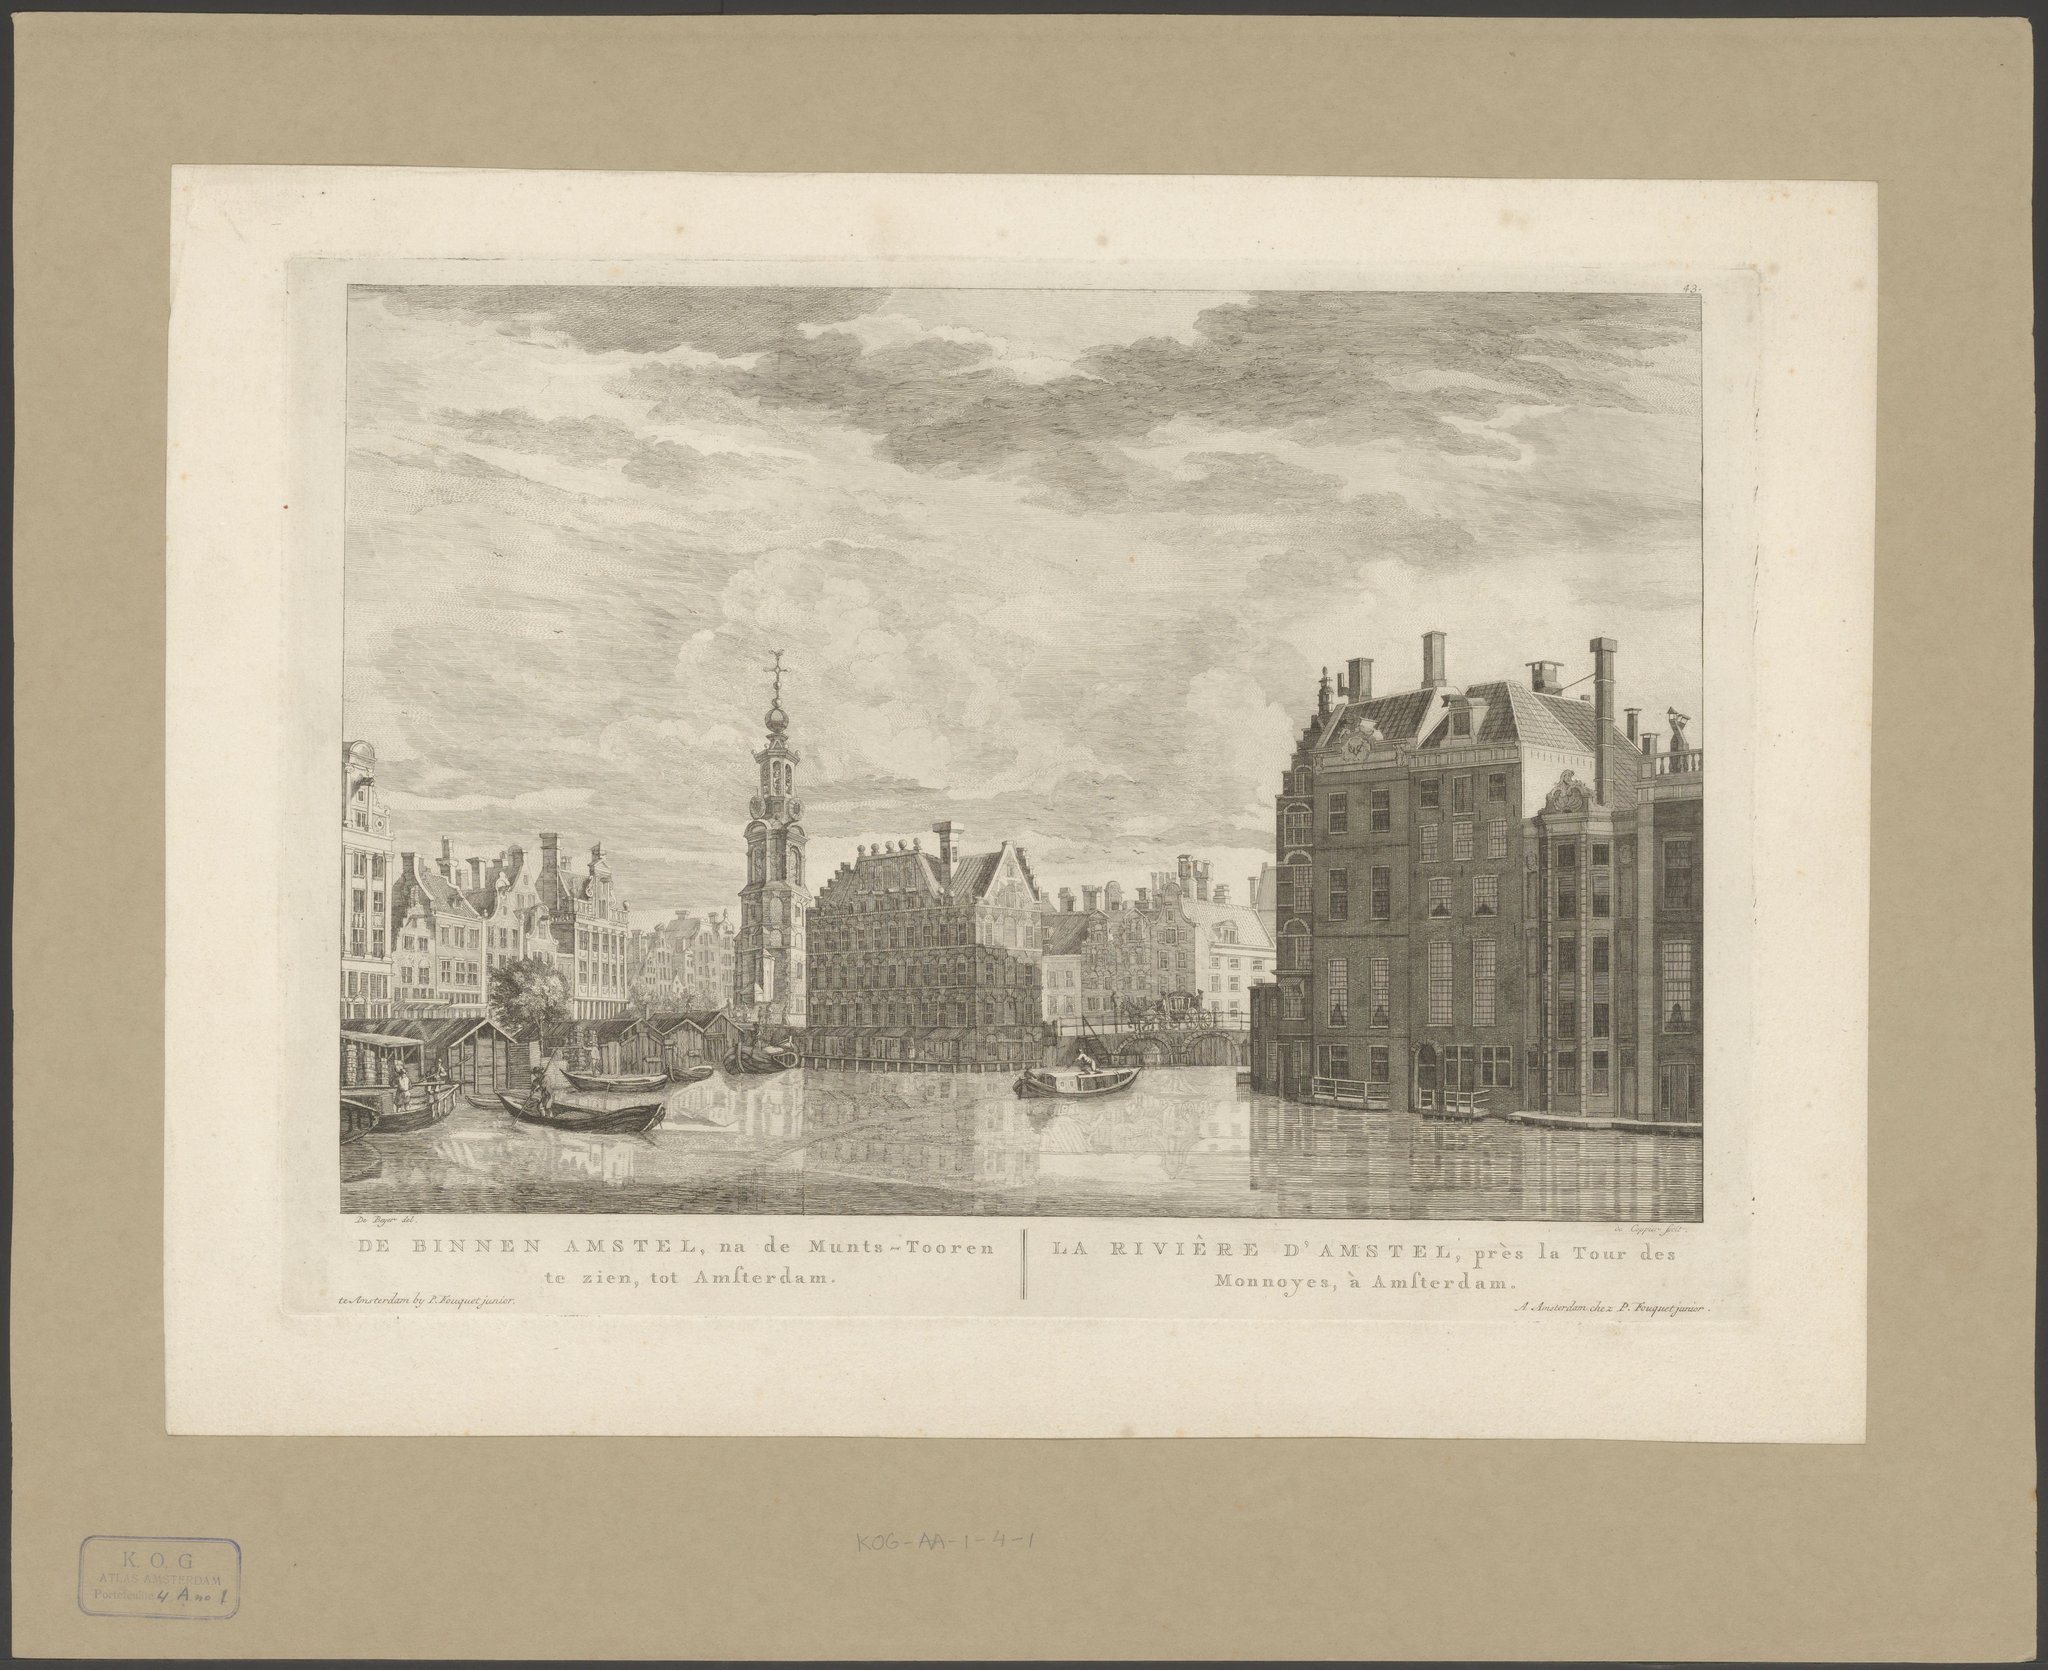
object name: print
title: De Binnen Amstel, na de Munts-Tooren te zien, tot Amsterdam / La riviêre d'Amstel, près la Tour des Monnoyes, à Amsterdam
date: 1774-1783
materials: paper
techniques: engraving, etching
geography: amsterdam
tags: tower, clock tower ~ monumental adornment, city-view in general; 'veduta', canal, bridge in city across river, canal, etc.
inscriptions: collector's mark: ‘4A no 1’ Lugt 1641b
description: Deze prent is ook gebruikt in de zogenaamde Atlas van Fouquet.* Pierre Fouquet gaf vanaf 1760 stadsgezichten van Amsterdam - naar tekeningen van verschillende kunstenaars, gemaakt door verschillende prentmakers - uit. Deze prenten werden aanvankelijk los of in series verkocht. Zoals toen gebruikelijk kon de koper de prenten zelf laten inbinden. Hiertoe gaf Fouquet tussen 1778 en 1783 een titelblad, plattegrond en inhoudsopgave van de tot dusver 100 uitgegeven prenten uit (1). Gezien de inhoud afhankelijk was van wat de koper had verzameld verschilt de inhoud van de verschillende bewaarde Fouquetatlassen onder deze titel sterk. Ook zijn er exemplaren bekend waar tevens andere prenten aan zijn toegevoegd. Omdat er behoefte bleek aan uitleg bij de platen werd in 1783 een nieuwe versie van de atlas uitgegeven, aangevuld met tekst en twee prenten. De aangegeven volgorde veranderde maar de platen van de al eerder uitgegeven prenten bleven ongewijzigd. Deze uitgave werd in opdracht van Fouquet gedrukt bij Daniël Jean Changuion en Petrus den Hengst (2). Een tiental platen werd bijgewerkt en verscheen, met nieuw impressum, in het vervolg van Wagenaars geschiedenis van Amsterdam, uitgeven door Petrus Conradi en Folkert van der Plaats (3). Een aantal jaar na het overlijden van Fouquet kwam Evert Maaskamp met een nieuwe uitgave van de atlas, met verbeterde tekst en toevoeging van twee prenten. Op alle platen verwijderde hij het oude en liet hij zijn eigen impressum zetten (4). De huidige staat van de prent komt voor in exemplaren van de onder (1) en (2) genoemde werken. * Onder de Atlas van Fouquet of Fouquetatlas verstaan we de hieronder vermelde publicaties (1), (2) en (4). (1). Afbeeldingen van de wyd-vermaarde koopstad Amsterdam benevens des zelvs voornaamste gebouwen en gezigten alle naar het leeven getekend / Receuil des edifices les plus considerables et des plus belles vues, de la fameuse ville d'Amsterdam, dessinées d'après nature. Amsterdam: Pierre Fouquet, 1778-1783. (2). Nieuwe atlas, van de voornaamste gebouwen en gezigten der stad Amsterdam, met derzelver beknopte beschryvingen. 2 delen. Amsterdam: Daniël Jean Changuion en Petrus den Hengst [in opdracht van Pierre Fouquet], 1783. (3). Stijl, Simon. Amsterdam, in zyne geschiedenissen, voorregten, koophandel, gebouwen, kerkenstaat, schoolen, schutterye, gilden en regeeringe, beschreeven. Om te dienen ten vervolge op het werk van Jan Wagenaar (…). 10 delen. Amsterdam en Harlingen: Petrus Conradi en Folkert van der Plaats, 1788-1801. (4). Nieuwe atlas, van de voornaamste gebouwen en gezigten der stad Amsterdam. Met derzelver beknopte beschryvingen. Amsterdam: Evert Maaskamp, 1805. * Het aantal vermelde staten is gebaseerd op het aantal gevonden staten. Mogelijk zijn er meer staten van deze prent. Voor eerste bekende staat RP-P-1921-303. Voor tweede of derde bekende staat zie RP-P-1905-388.